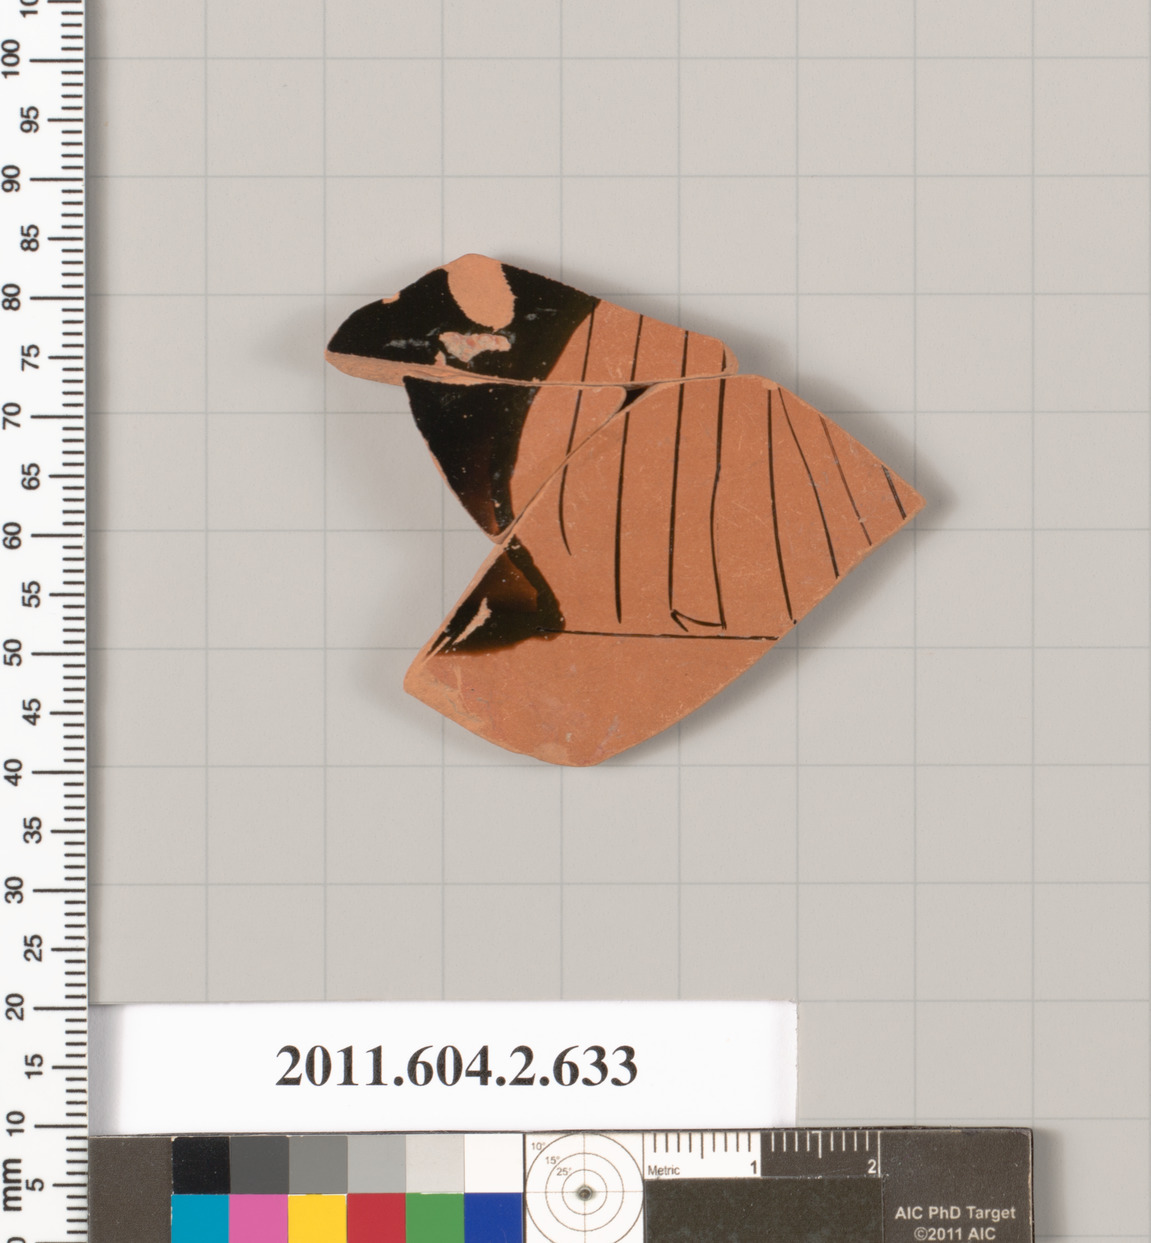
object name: column krater fragment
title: Terracotta fragment of a column-krater (bowl for mixing wine and water)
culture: greek, attic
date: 460-440 BCE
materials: terracotta